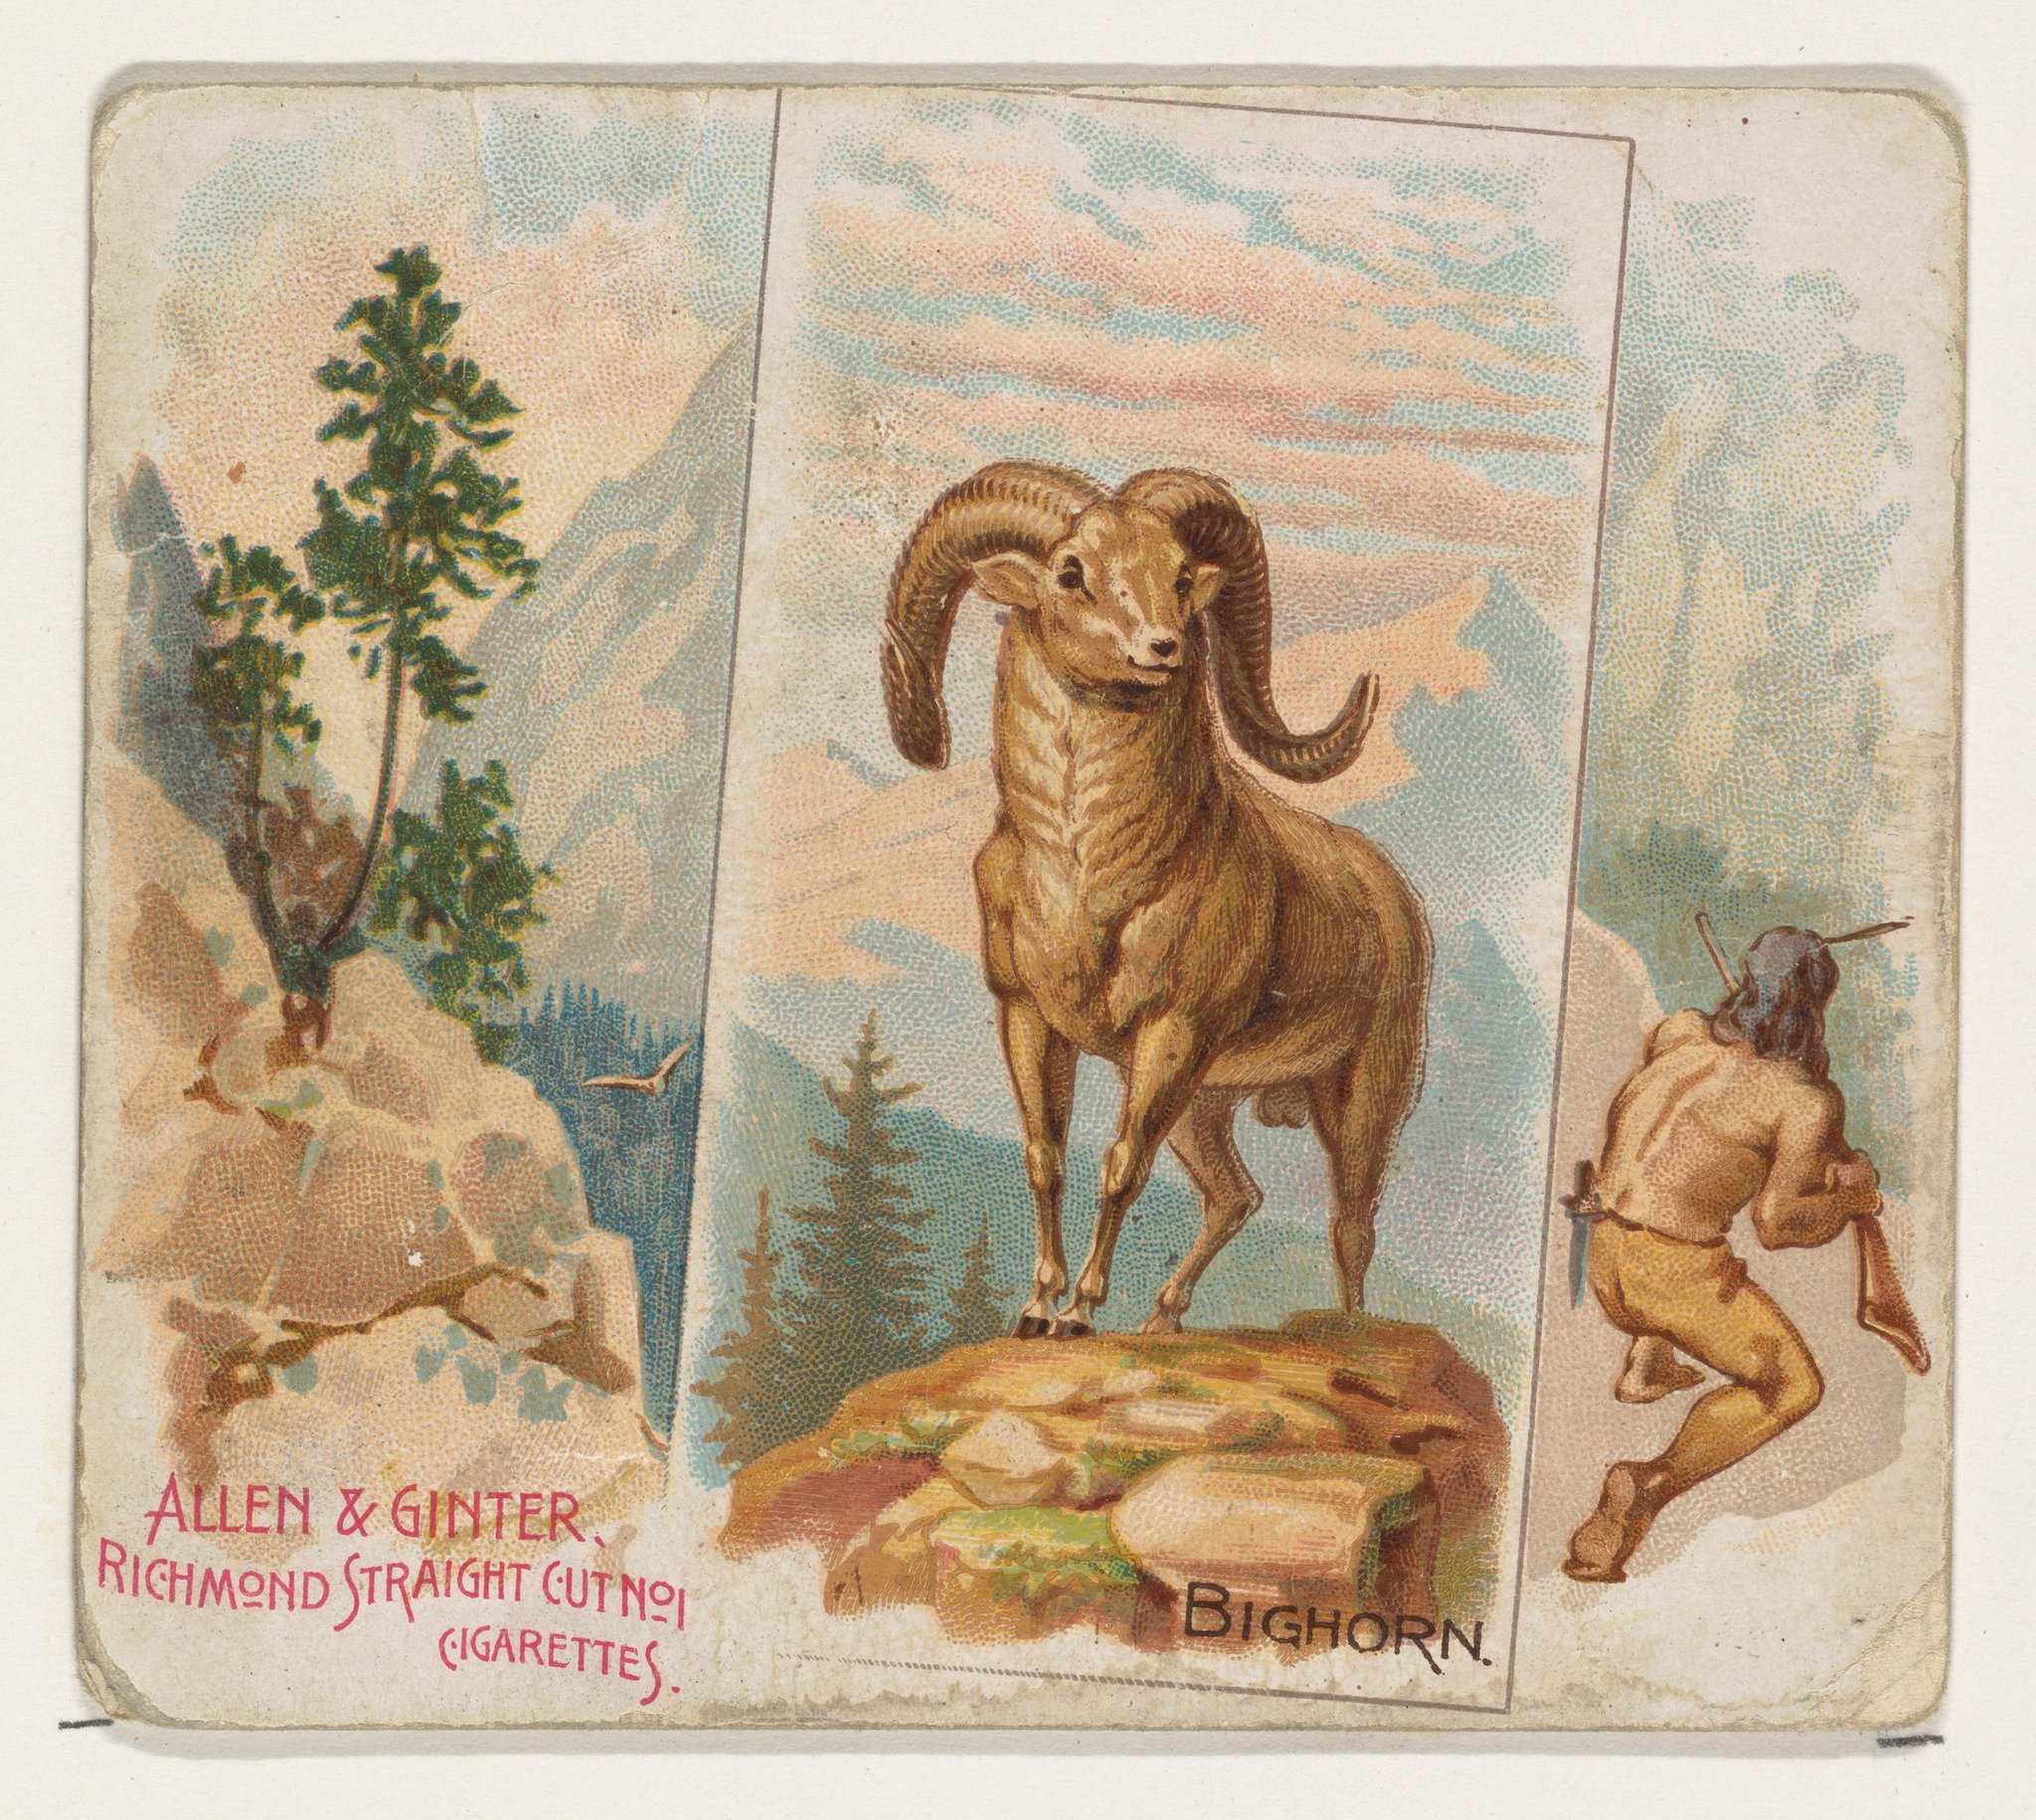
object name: print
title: Bighorn, from Quadrupeds series (N41) for Allen & Ginter Cigarettes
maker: allen & ginter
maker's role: publisher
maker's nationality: american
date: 1890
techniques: color lithograph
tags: sheep